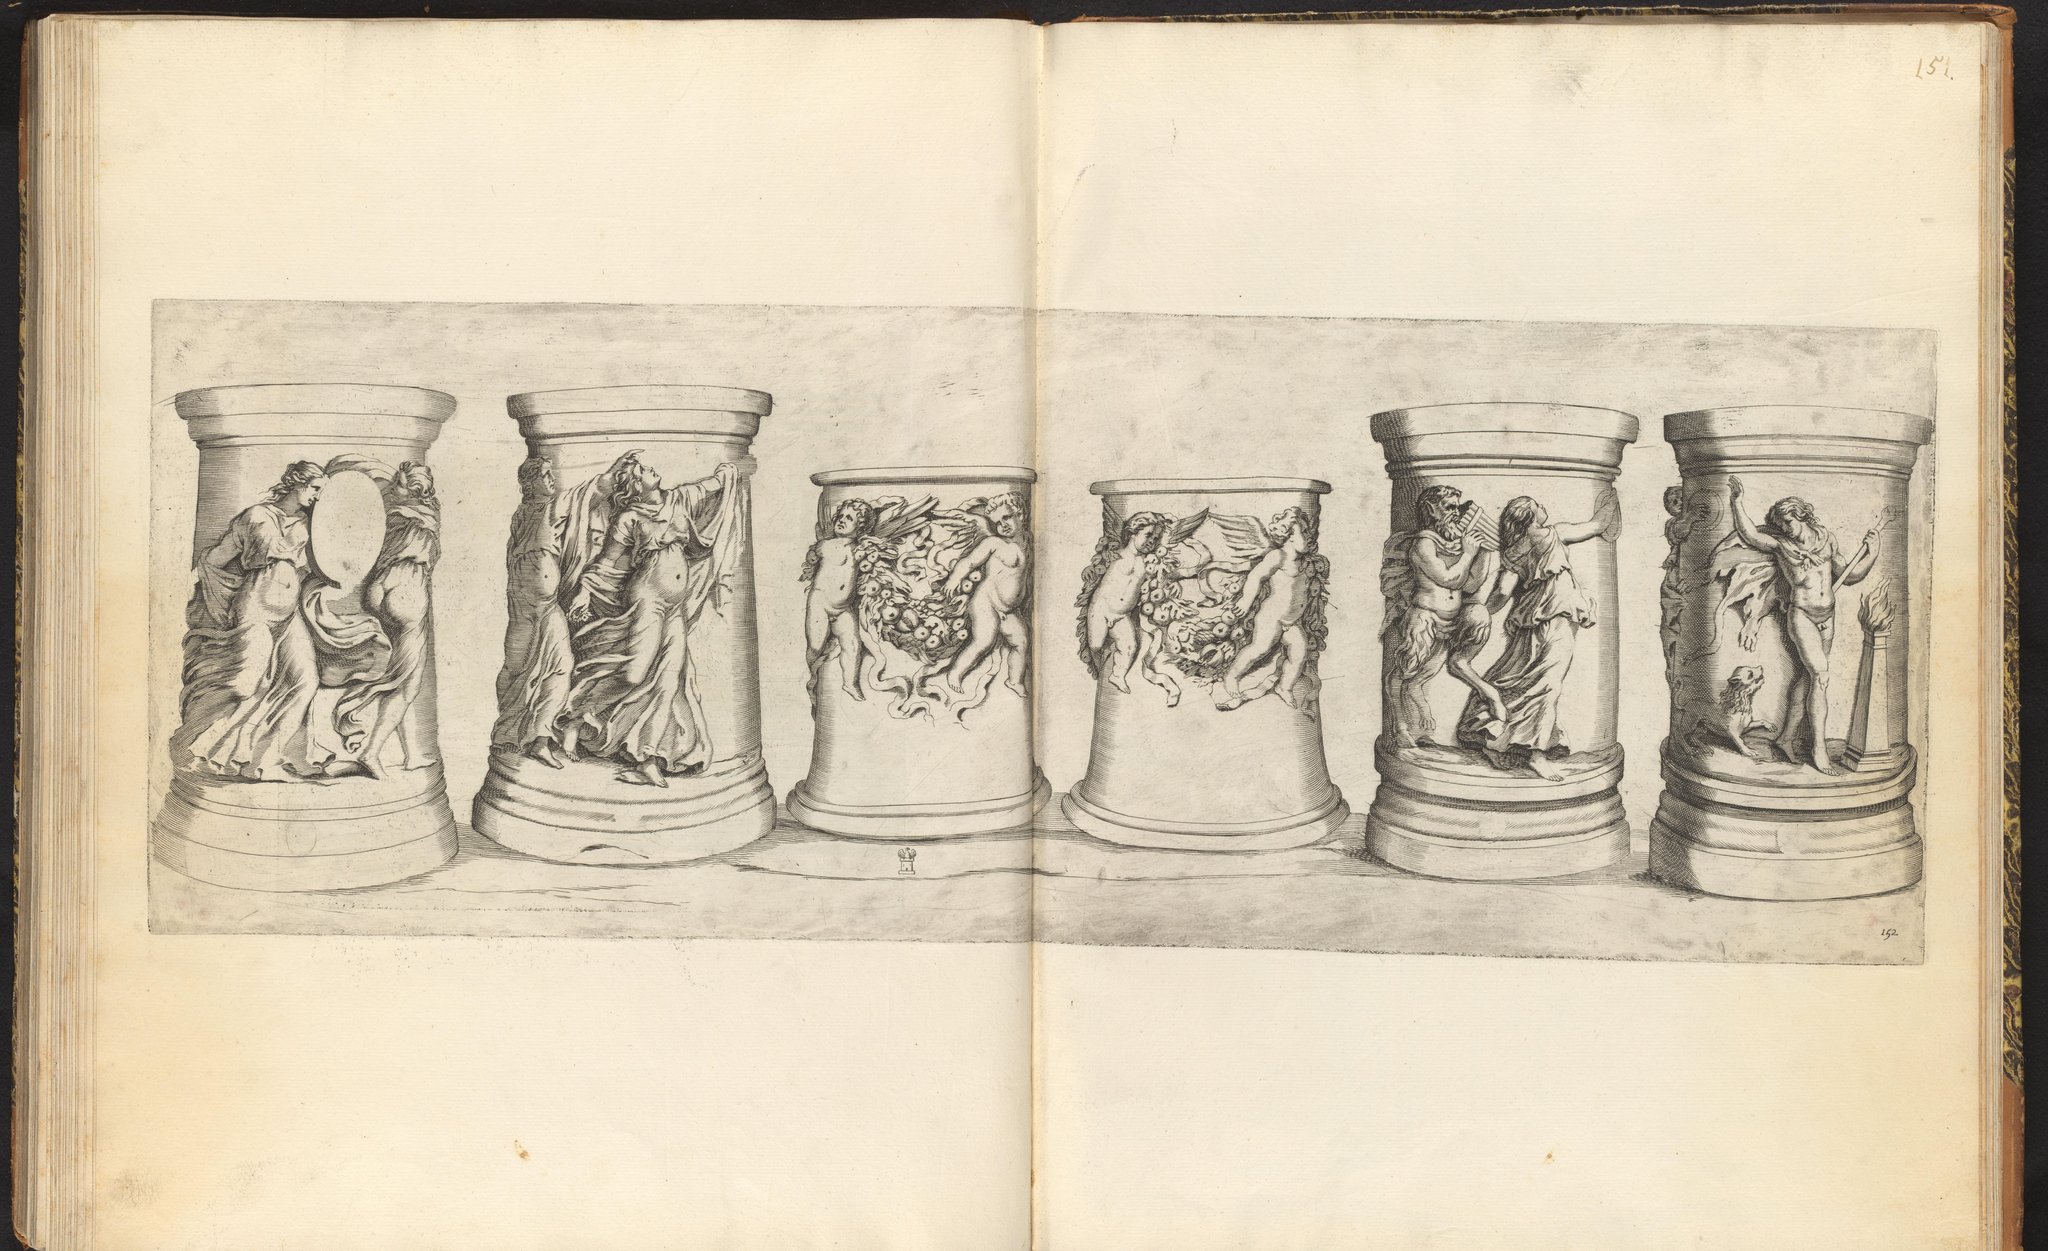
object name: album leaf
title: Galleria Giustiniana del Marchese Vincenzo Giustiniani II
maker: gabriel ladame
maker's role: print maker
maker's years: 1613-1679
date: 1636-1647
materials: paper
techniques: engraving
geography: rome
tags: piece of sculpture, reproduction of a piece of sculpture, ornament ~ festoon, garland, cupids: 'amores', 'amoretti', 'putti'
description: De voor- en achterzijde van drie ronde piëdestallen. Op de twee aanzichten geheel links een optocht van vrouwfiguren. Op de twee middelste aanzichten putti die een vruchtenguirlande dragen. Op de twee aanzichten geheel rechts een sater met panfluit en een man die een offer brengt. Midden onder de voorstelling het wapenschild van Vincenzo Giustiniani. Prent maakt deel uit van een album met een serie prenten naar de sculpturen in de verzameling in de Galleria Giustiniani te Rome.